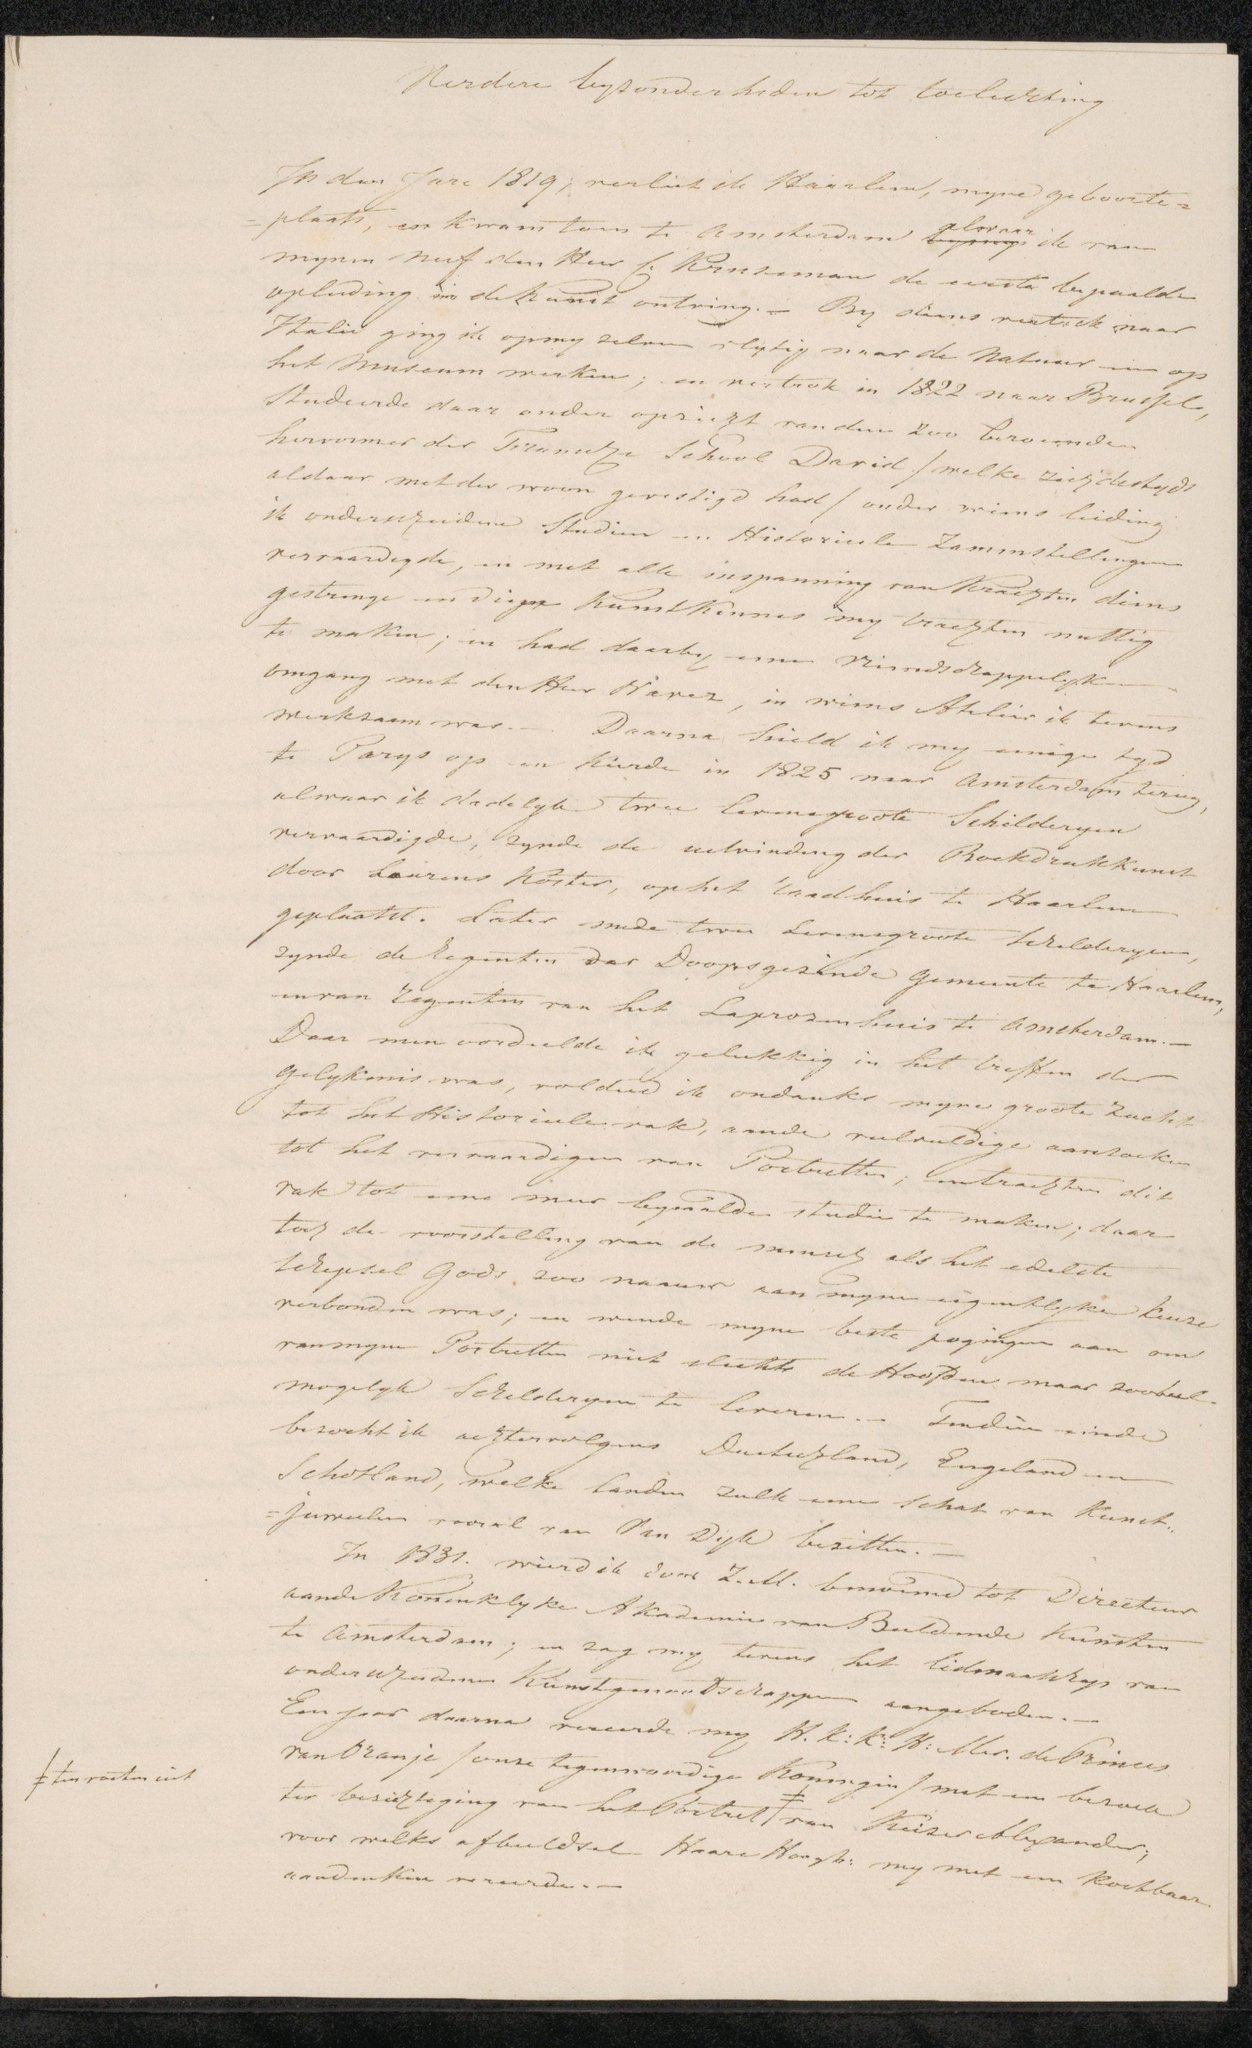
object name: letter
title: Brief aan anoniem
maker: jan adam kruseman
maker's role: draughtsman, painter, print maker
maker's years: 1804-1862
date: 1842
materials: ink, paper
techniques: pen, writing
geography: amsterdam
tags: paris, print maker, draughtsman, benoit taurel, martinus gerardus tetar van elven, painting (including book-illumination, miniature-painting), historical persons (portraits and scenes from the life), brussels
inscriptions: watermark